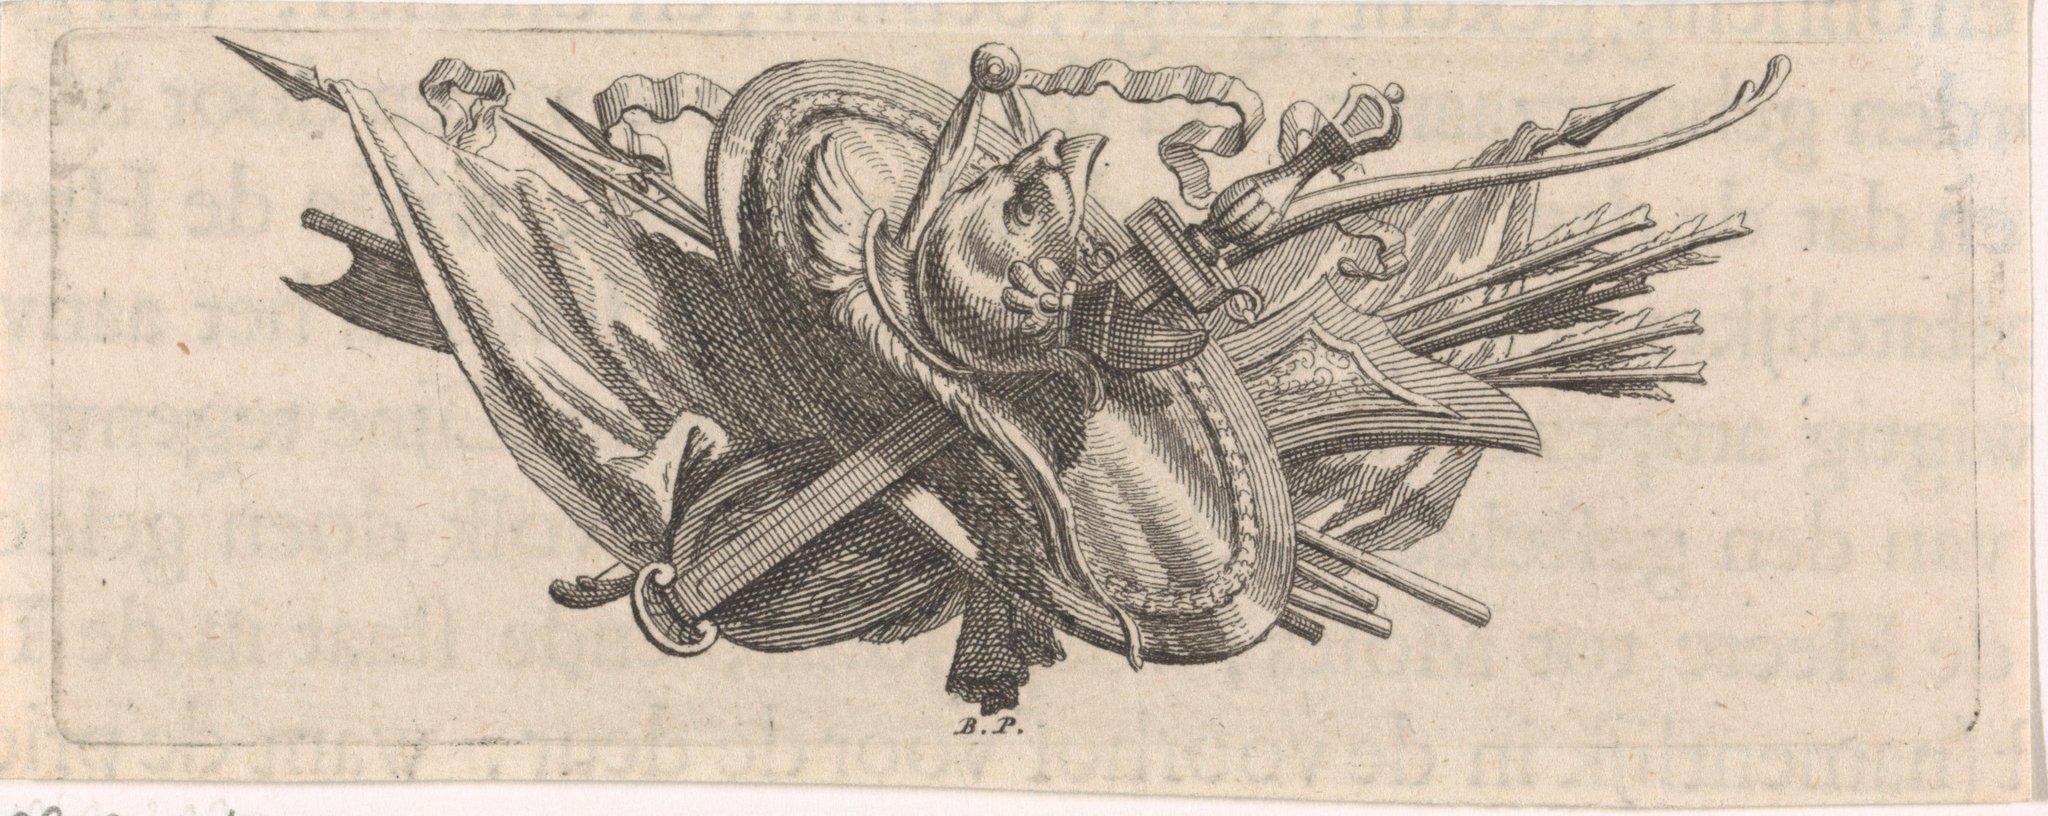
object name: ornament print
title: Wapentuig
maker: bernard picart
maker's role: draughtsman, print maker, publisher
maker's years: 1673-1733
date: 1683-1733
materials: paper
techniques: engraving, etching, letterpress printing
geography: amsterdam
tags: trophy, i.e.: decorative arrangement of symbolic or typical objects ~ ornament, 'tropaion', i.e. decorative ornament ~ weapons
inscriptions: collector's mark: Lugt 2228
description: Prent oorspronkelijk bedoeld voor: Figures de la Bible. Amsterdam, Bernard Picart, 1720. Prent ook gebruikt in: Taferelen der voornaamste geschiedenissen van het Oude en Nieuwe Testament (...) door de vermaarde kunstenaars Hoet, Houbraken, en Picart getekent (...) en met beschrijvingen uitgebreid. Den Haag: Pieter de Hondt, 1728. Prent kan mogelijk ook zijn gebruikt in andere bijbels.